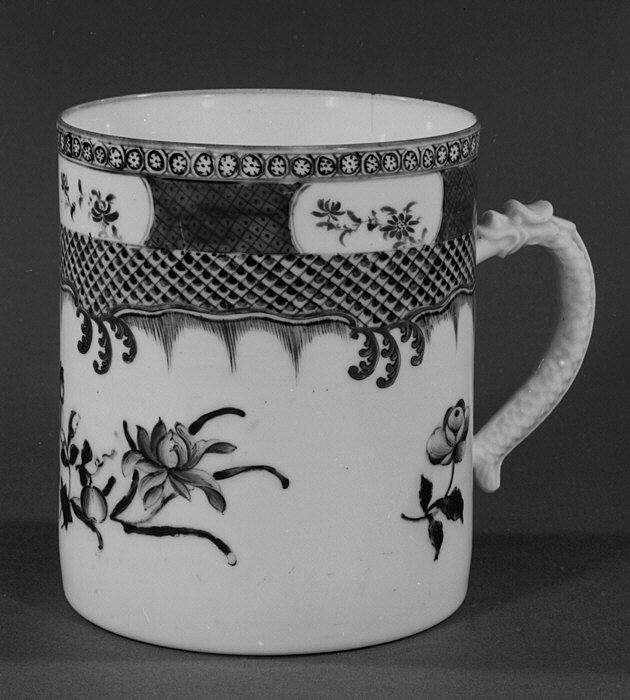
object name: mug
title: Mug (one of two)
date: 1775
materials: hard paste porcelain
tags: flowers